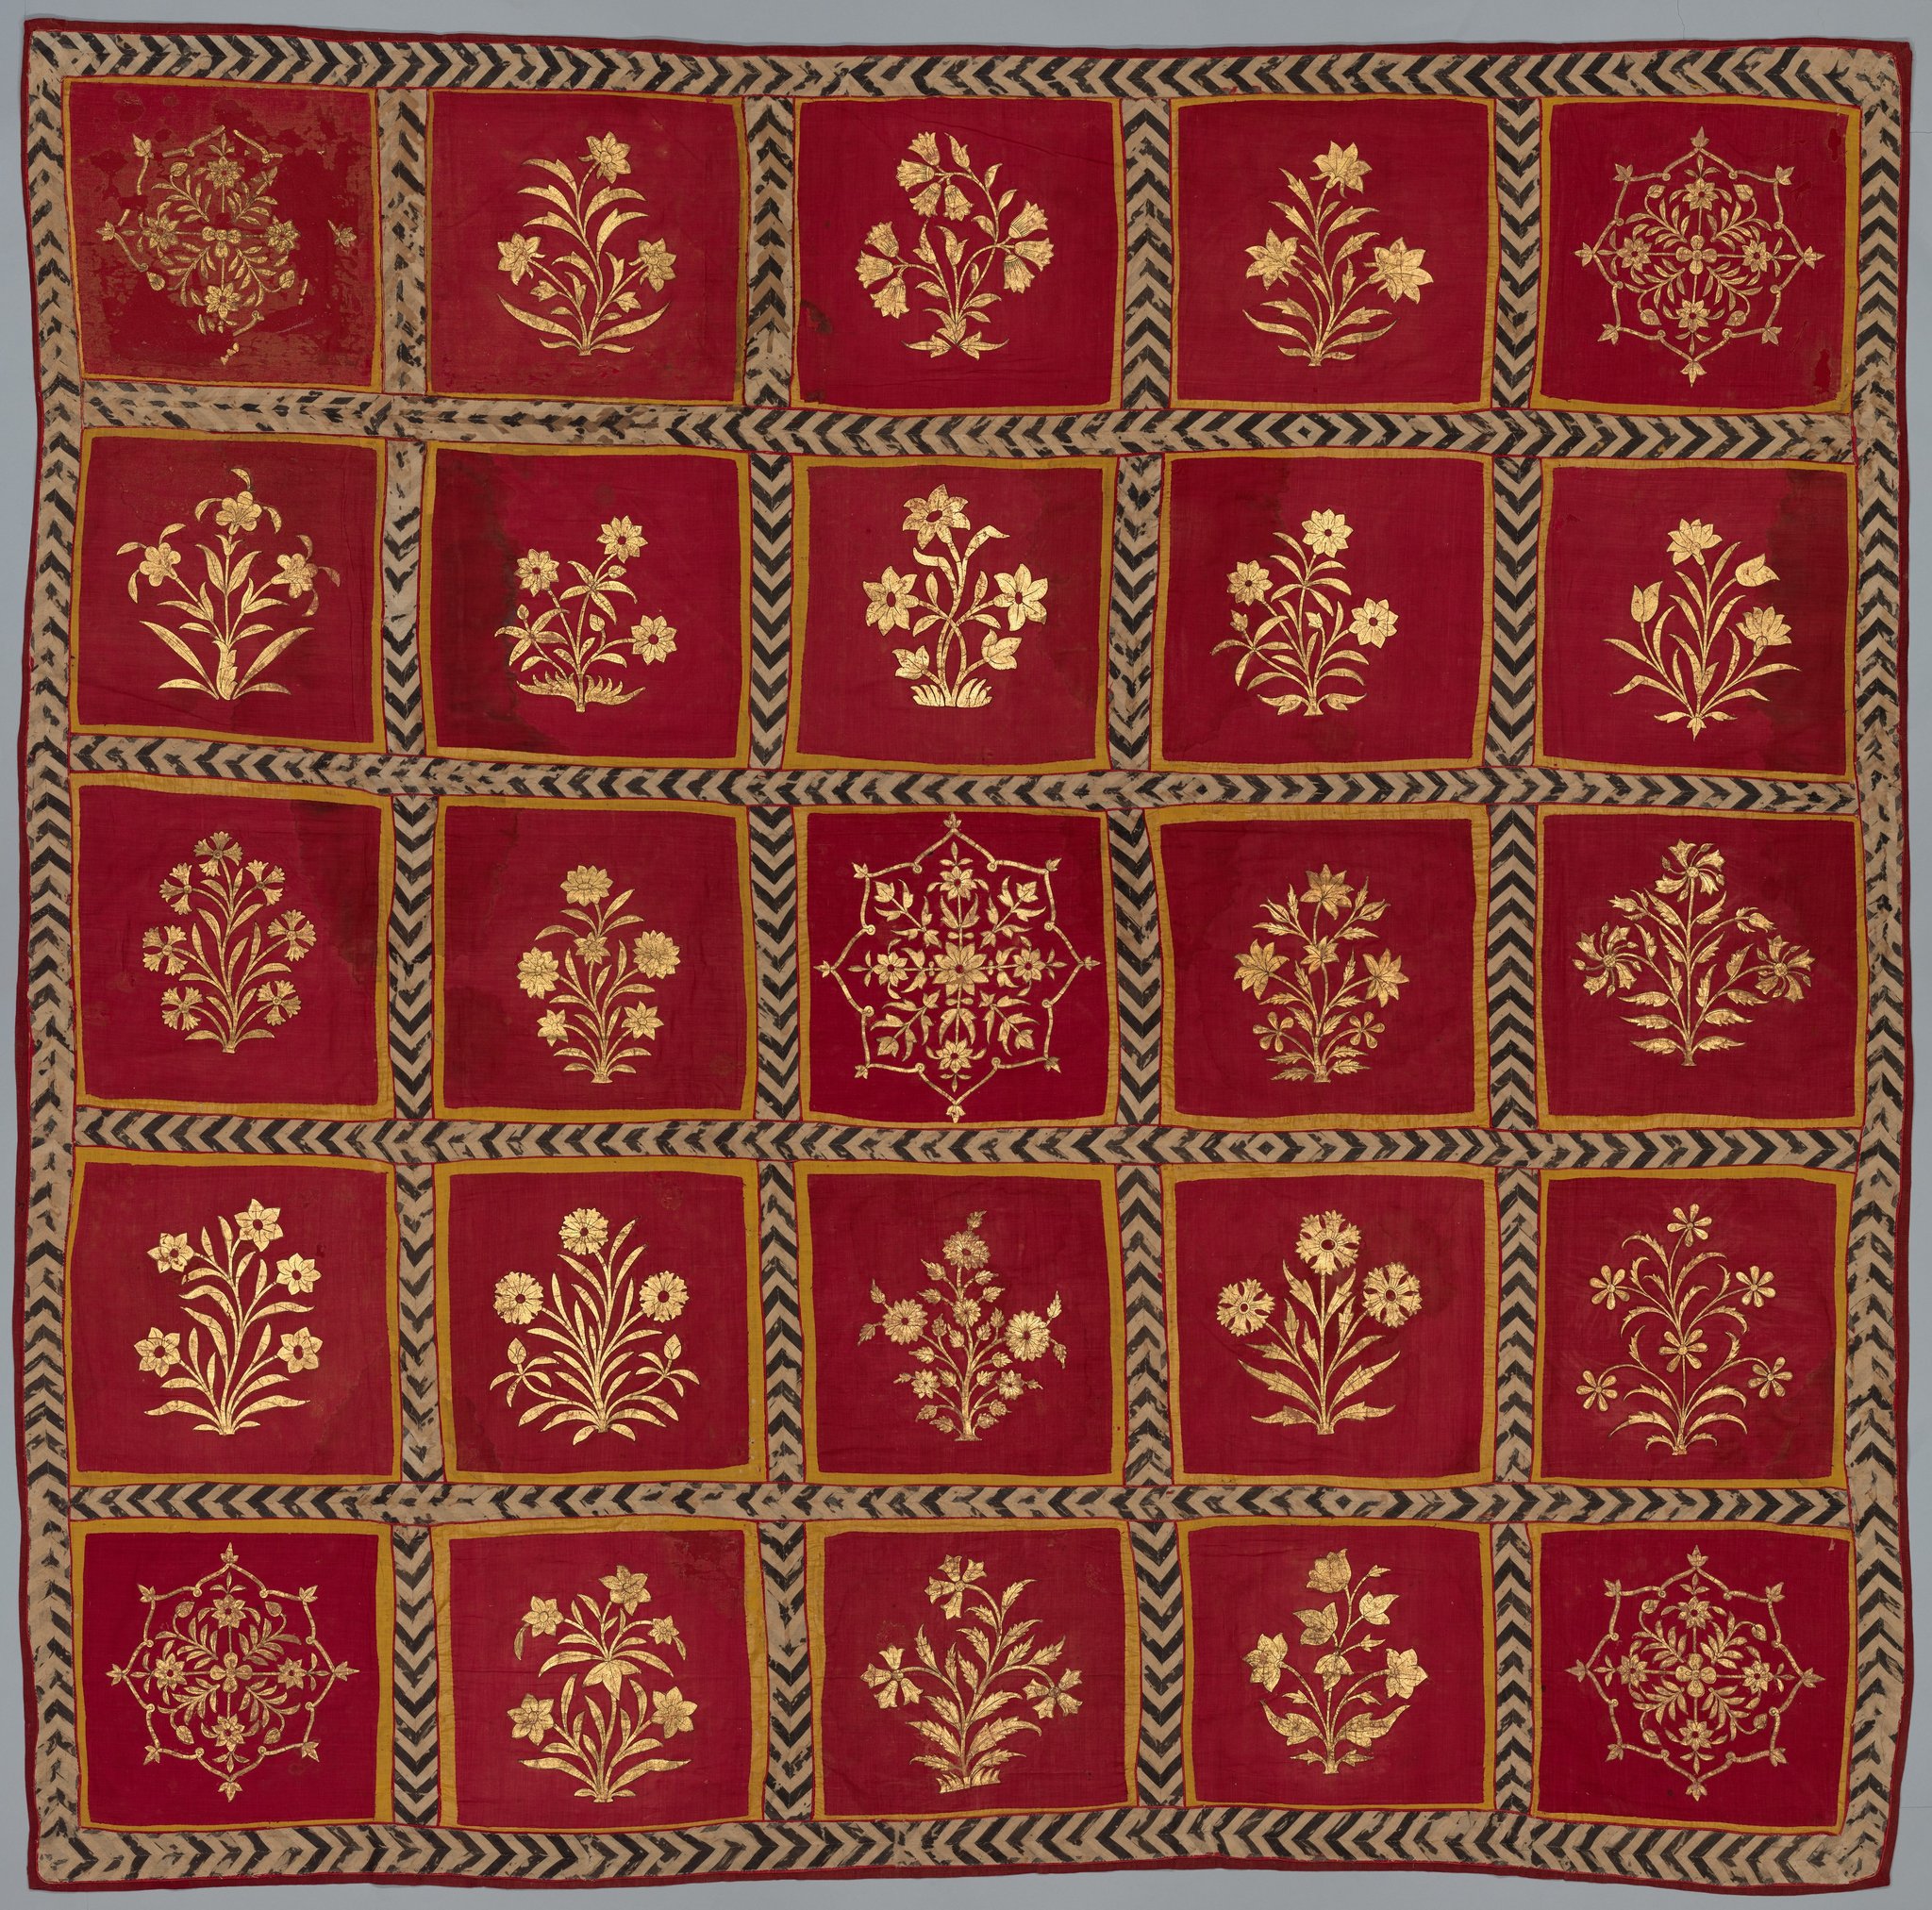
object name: hanging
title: Floral Canopy or Screen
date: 1601-1800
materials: cotton, gold leaf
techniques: painting, weave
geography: india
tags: flowers